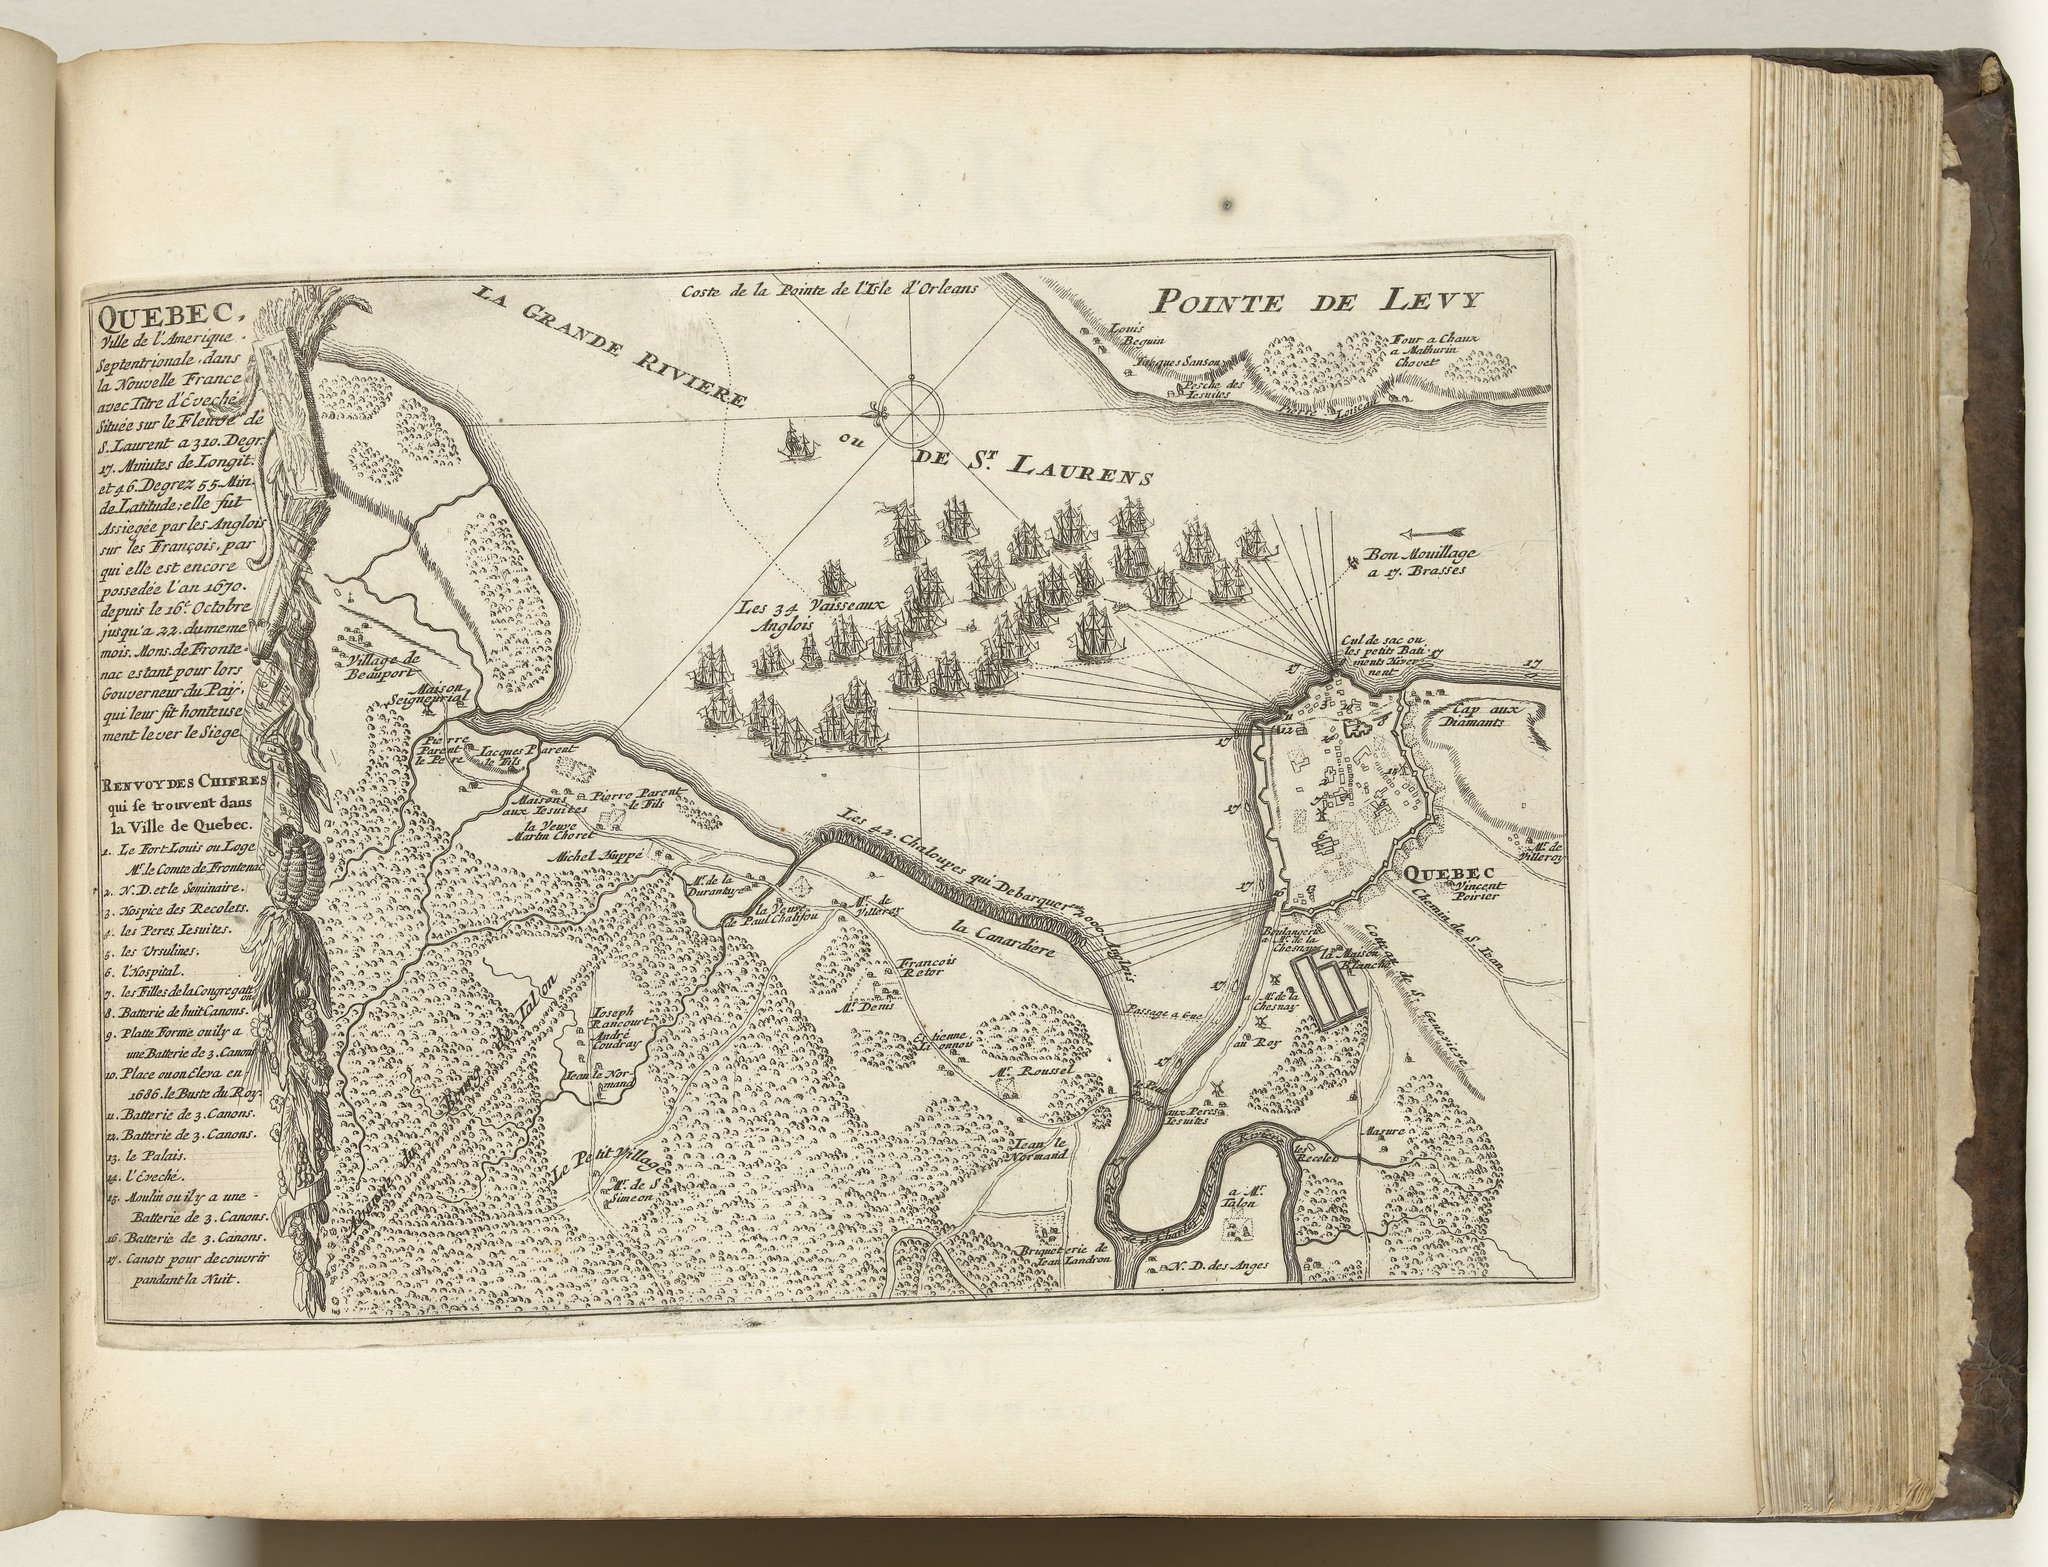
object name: map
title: Les forces de l'Europe, ou description des principales villes, avec leurs fortifications : dessignées par les meilleurs ingenieurs, particulierement celles (...) de la France, dont les plans ont esté levez par M. de Vauban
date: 1693-1696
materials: paper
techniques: etching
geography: paris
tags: maps of separate countries or regions, battle (+ land forces), québec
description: Aanval door Engelse schepen op de Fransen in de stad Québec, de aanval wordt afgeslagen, 16-22 oktober 1690. Kaart van Québc en omgeving met de Engelse vloot op de Saint Lawrencerivier voor de stad. Onderdeel van het vijfde deel (1696) van het prentwerk waarin gebundeld zijn de acht delen van Les forces de l'Europe uitgegeven tussen 1693-1697. Het prentwerk bestaat uit 175 platen met plannen (afkomstig van Sébastien Le Prestre, Seigneur de Vauban) van vermaarde sterke steden en vestingen in de Negenjarige Oorlog. Titel en opschriften in het Frans.